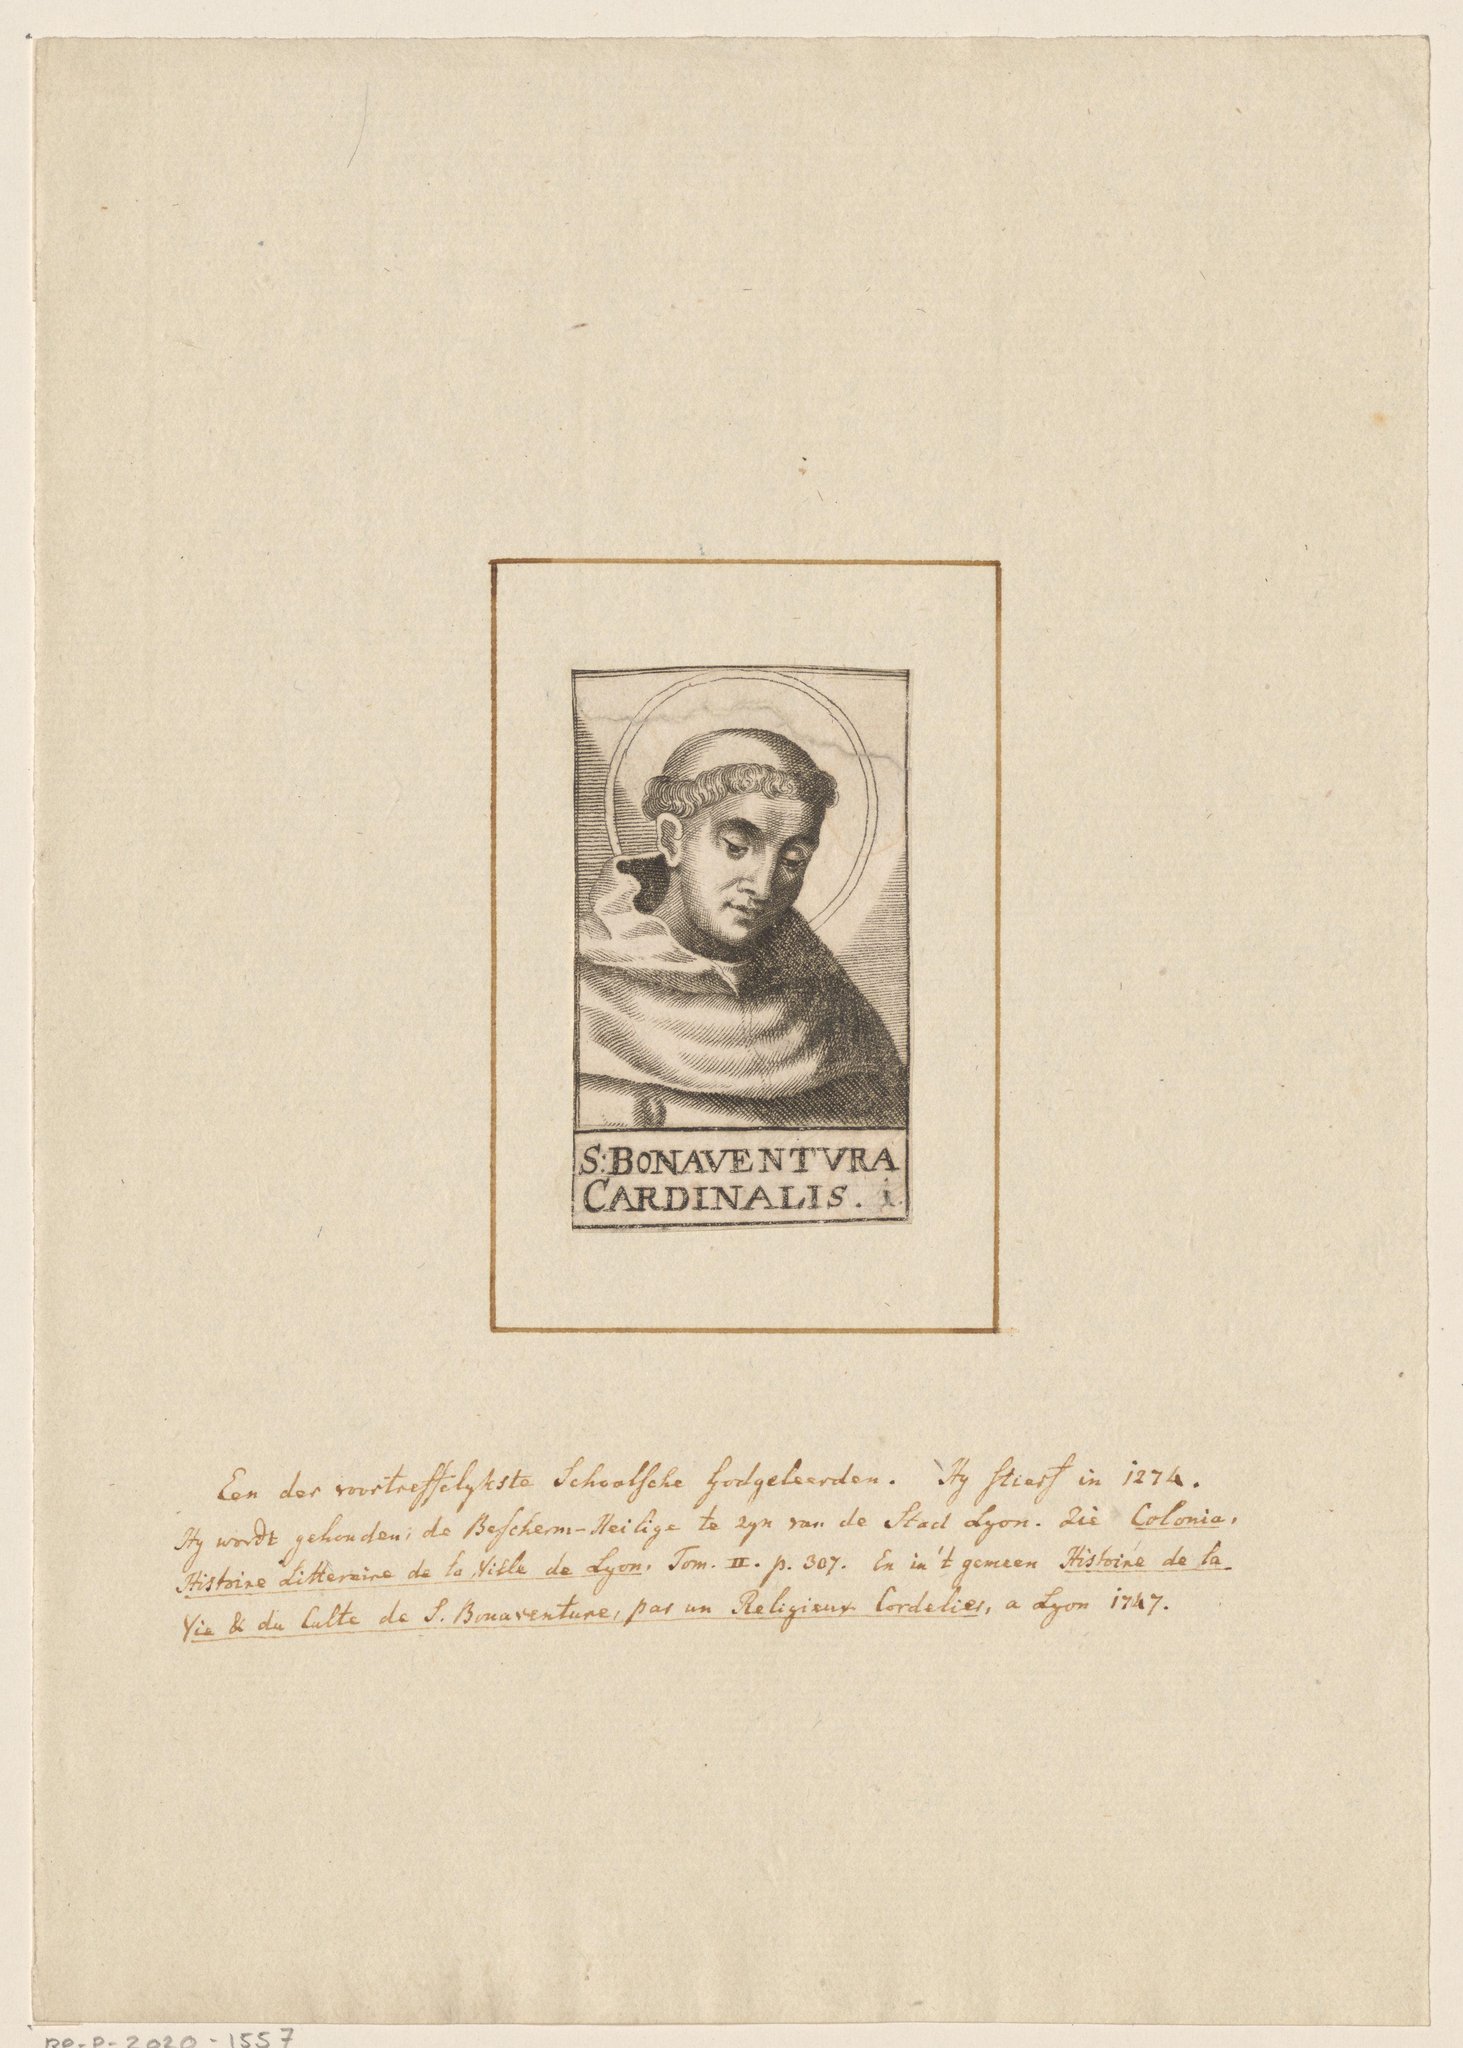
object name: book illustration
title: Portret van de heilige Bonaventura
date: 1688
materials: paper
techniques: engraving, etching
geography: nuremberg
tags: historical persons, bonaventura, cardinal bishop of albano and minister general of the franciscan order; possible attributes: book, cardinal's hat (sometimes hanging from a tree), crucifix (sometimes flowering)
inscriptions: inscription: ‘Een der voortreffelijkste schoolsche godgeleerden (...)’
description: Prent uit: Freher, Paul. Theatrum virorum eruditione clarorum. Neurenberg: Johann Hoffmann, 1688.